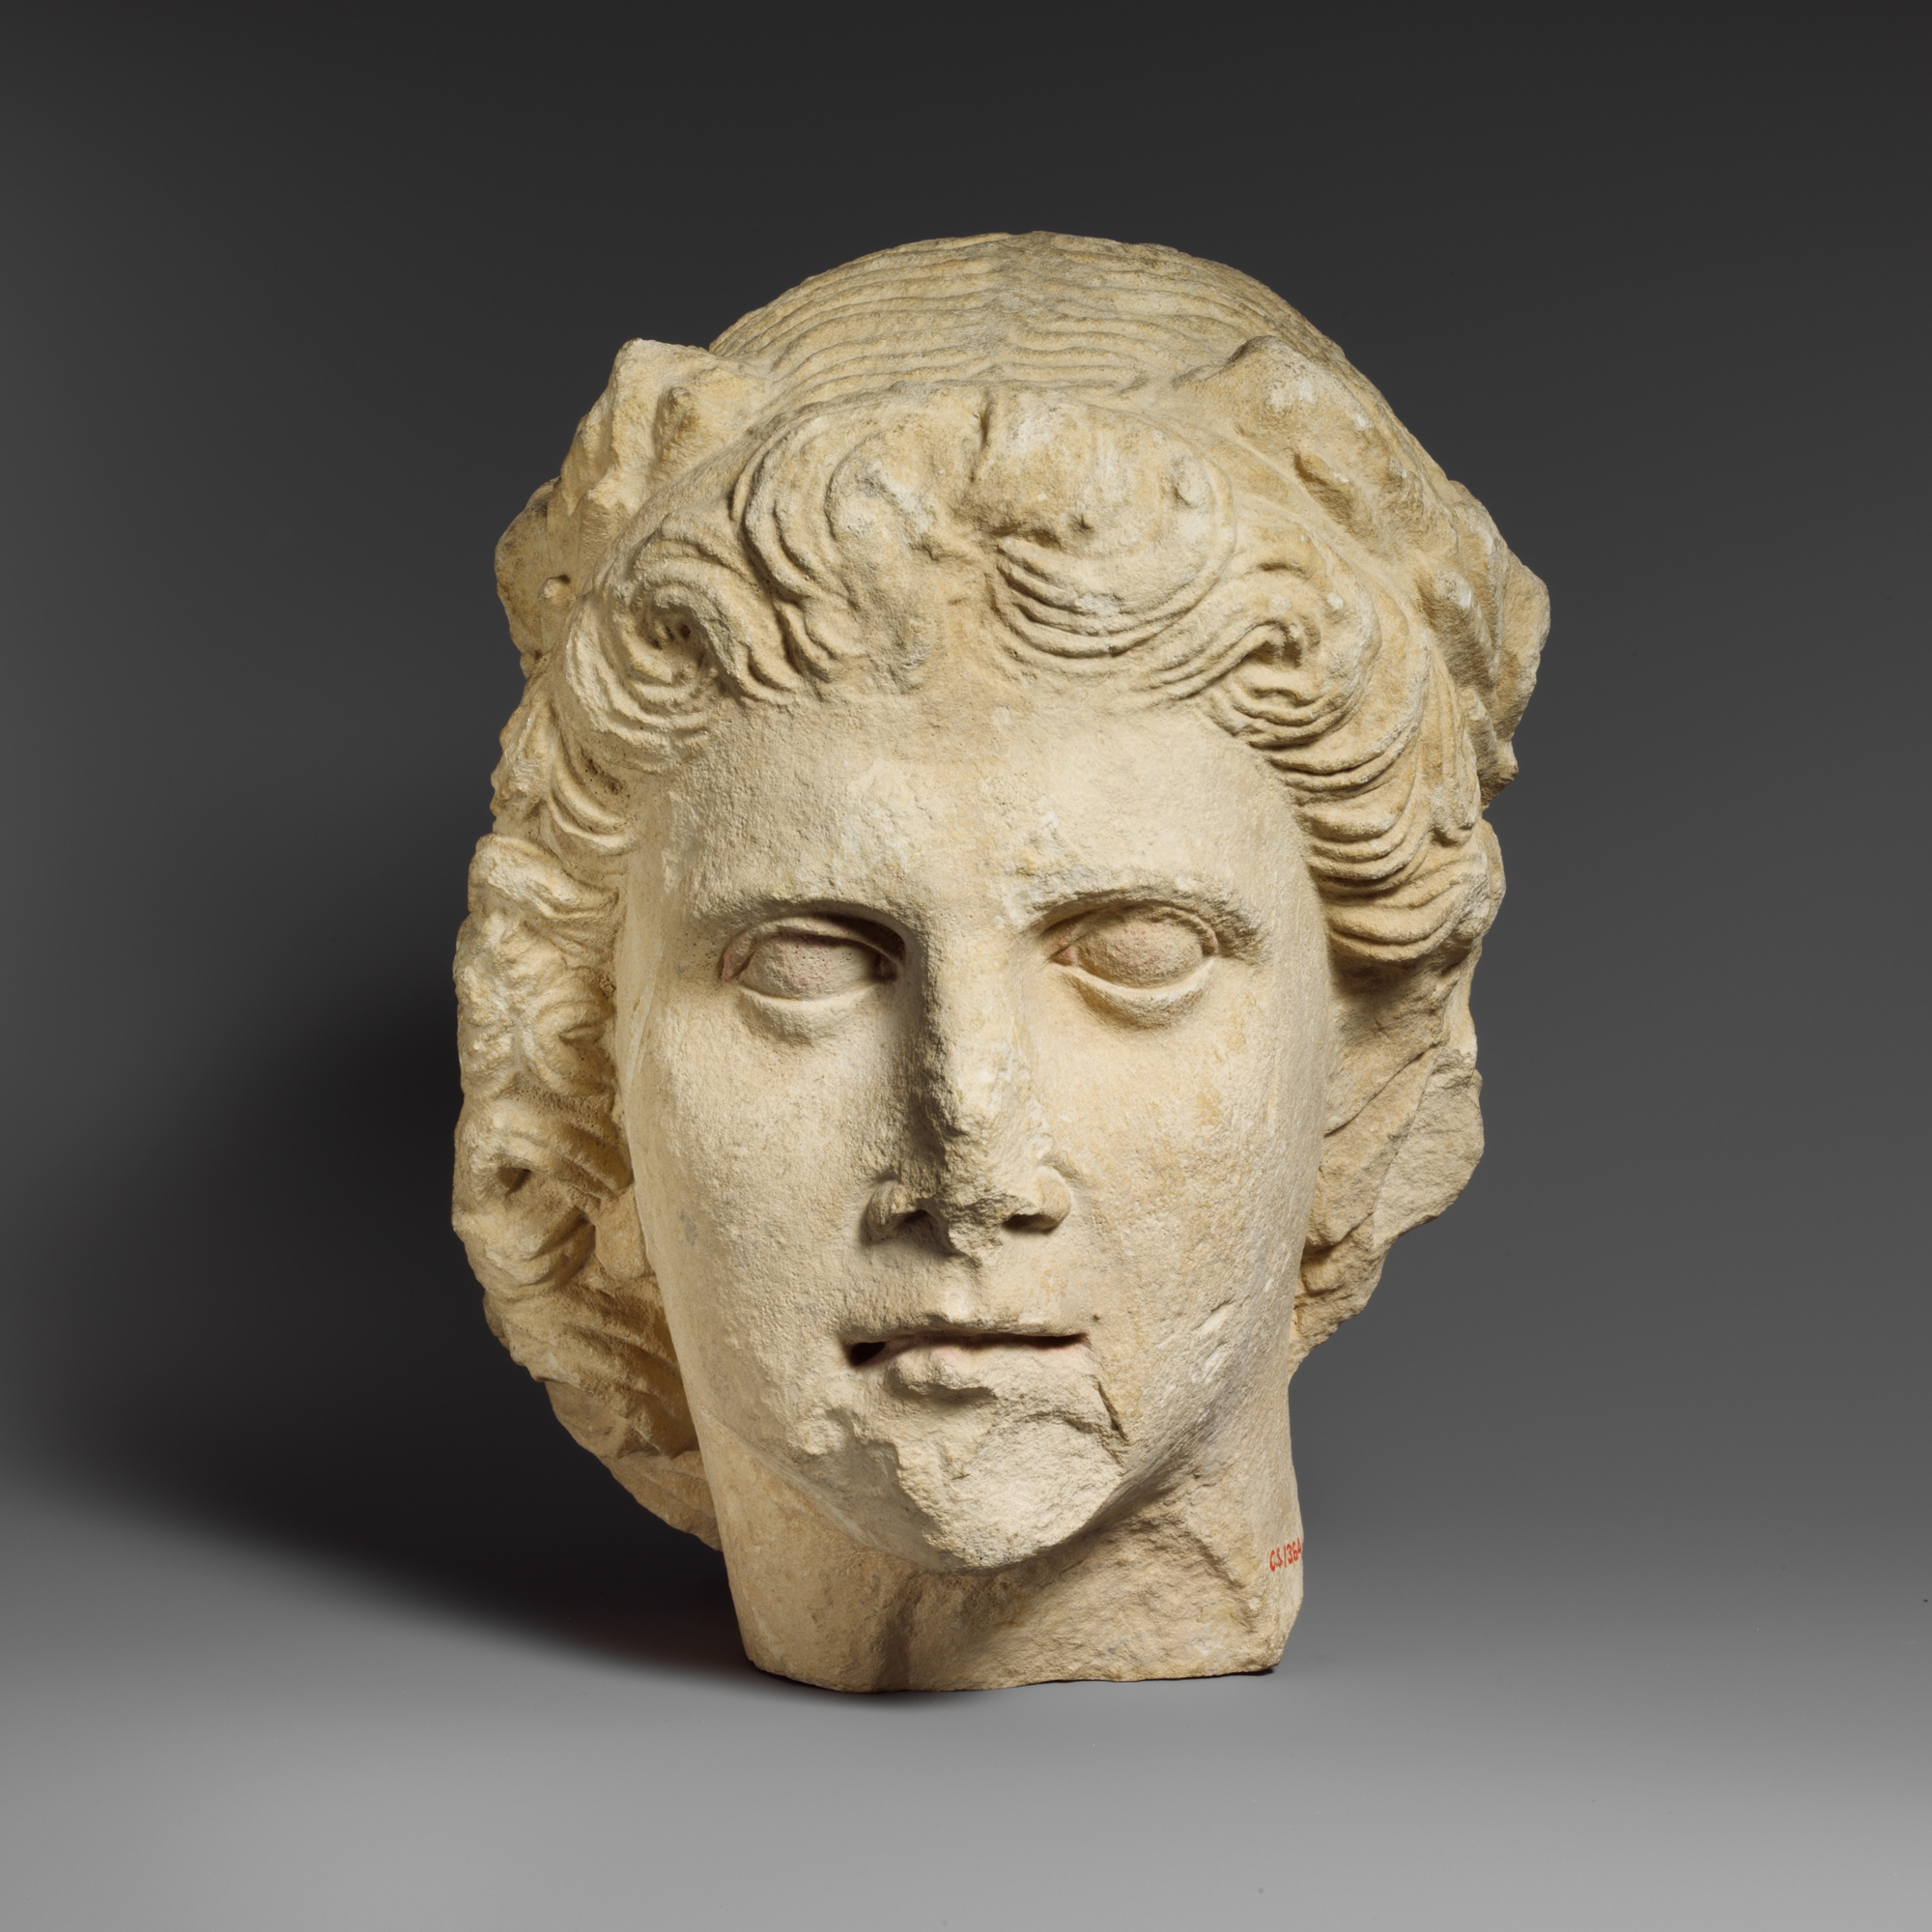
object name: head of a man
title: Limestone head of Apollo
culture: cypriot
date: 100-1 BCE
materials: limestone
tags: heads,apollo,wreaths